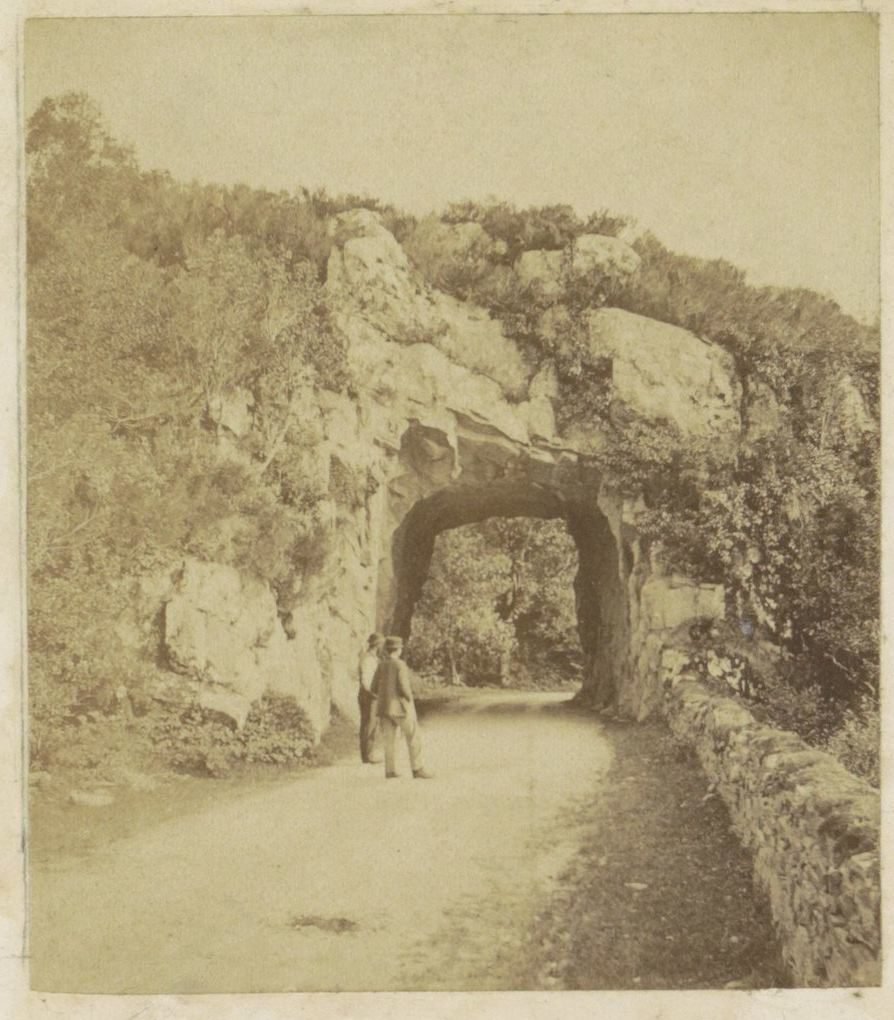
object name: photograph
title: Twee mannen bij een tunnel door rotsen in Engeland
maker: Anonymous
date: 1850-1870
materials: paper, photographic support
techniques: albumen print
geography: england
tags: underground road, tunnel, england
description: Onderdeel van Album met foto's van bezienswaardigheden en landschappen in Engeland en van kunst.